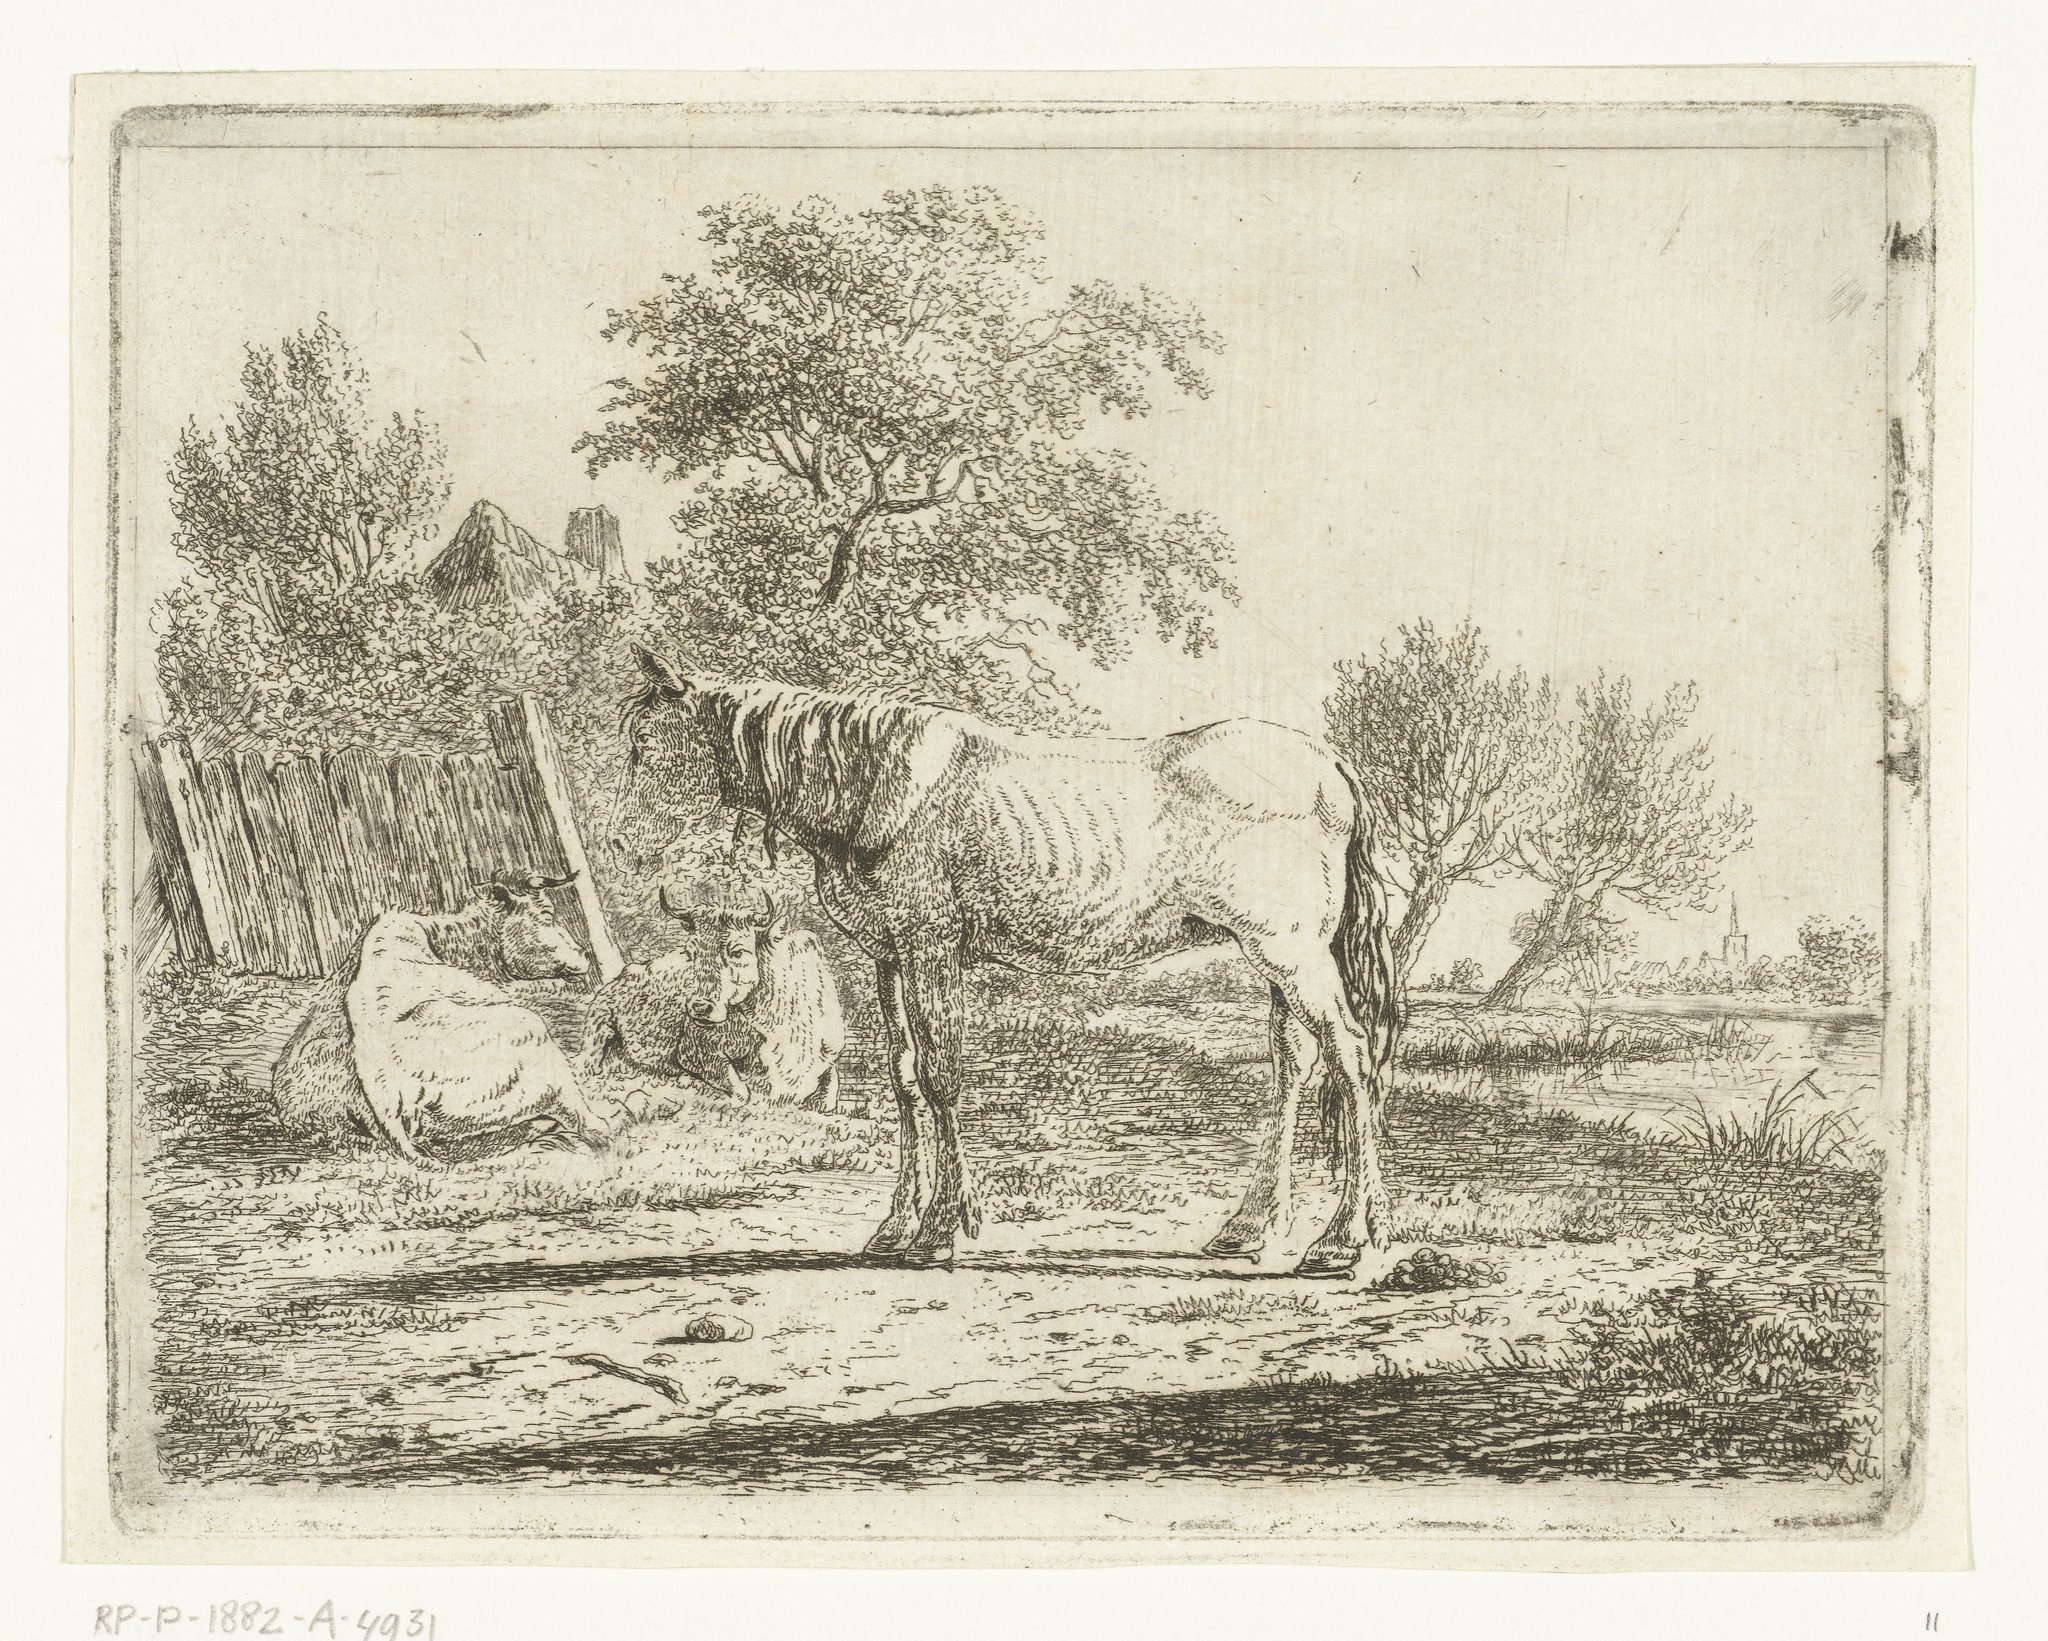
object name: print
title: Landschap met paard en twee koeien bij boerderij aan water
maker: cornelis bisschop (1762-1829)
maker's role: print maker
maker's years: 1762-1829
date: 1777-1829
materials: paper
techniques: etching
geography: netherlands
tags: cow, horse, farm or solitary house in landscape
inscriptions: collector's mark: Lugt 2228